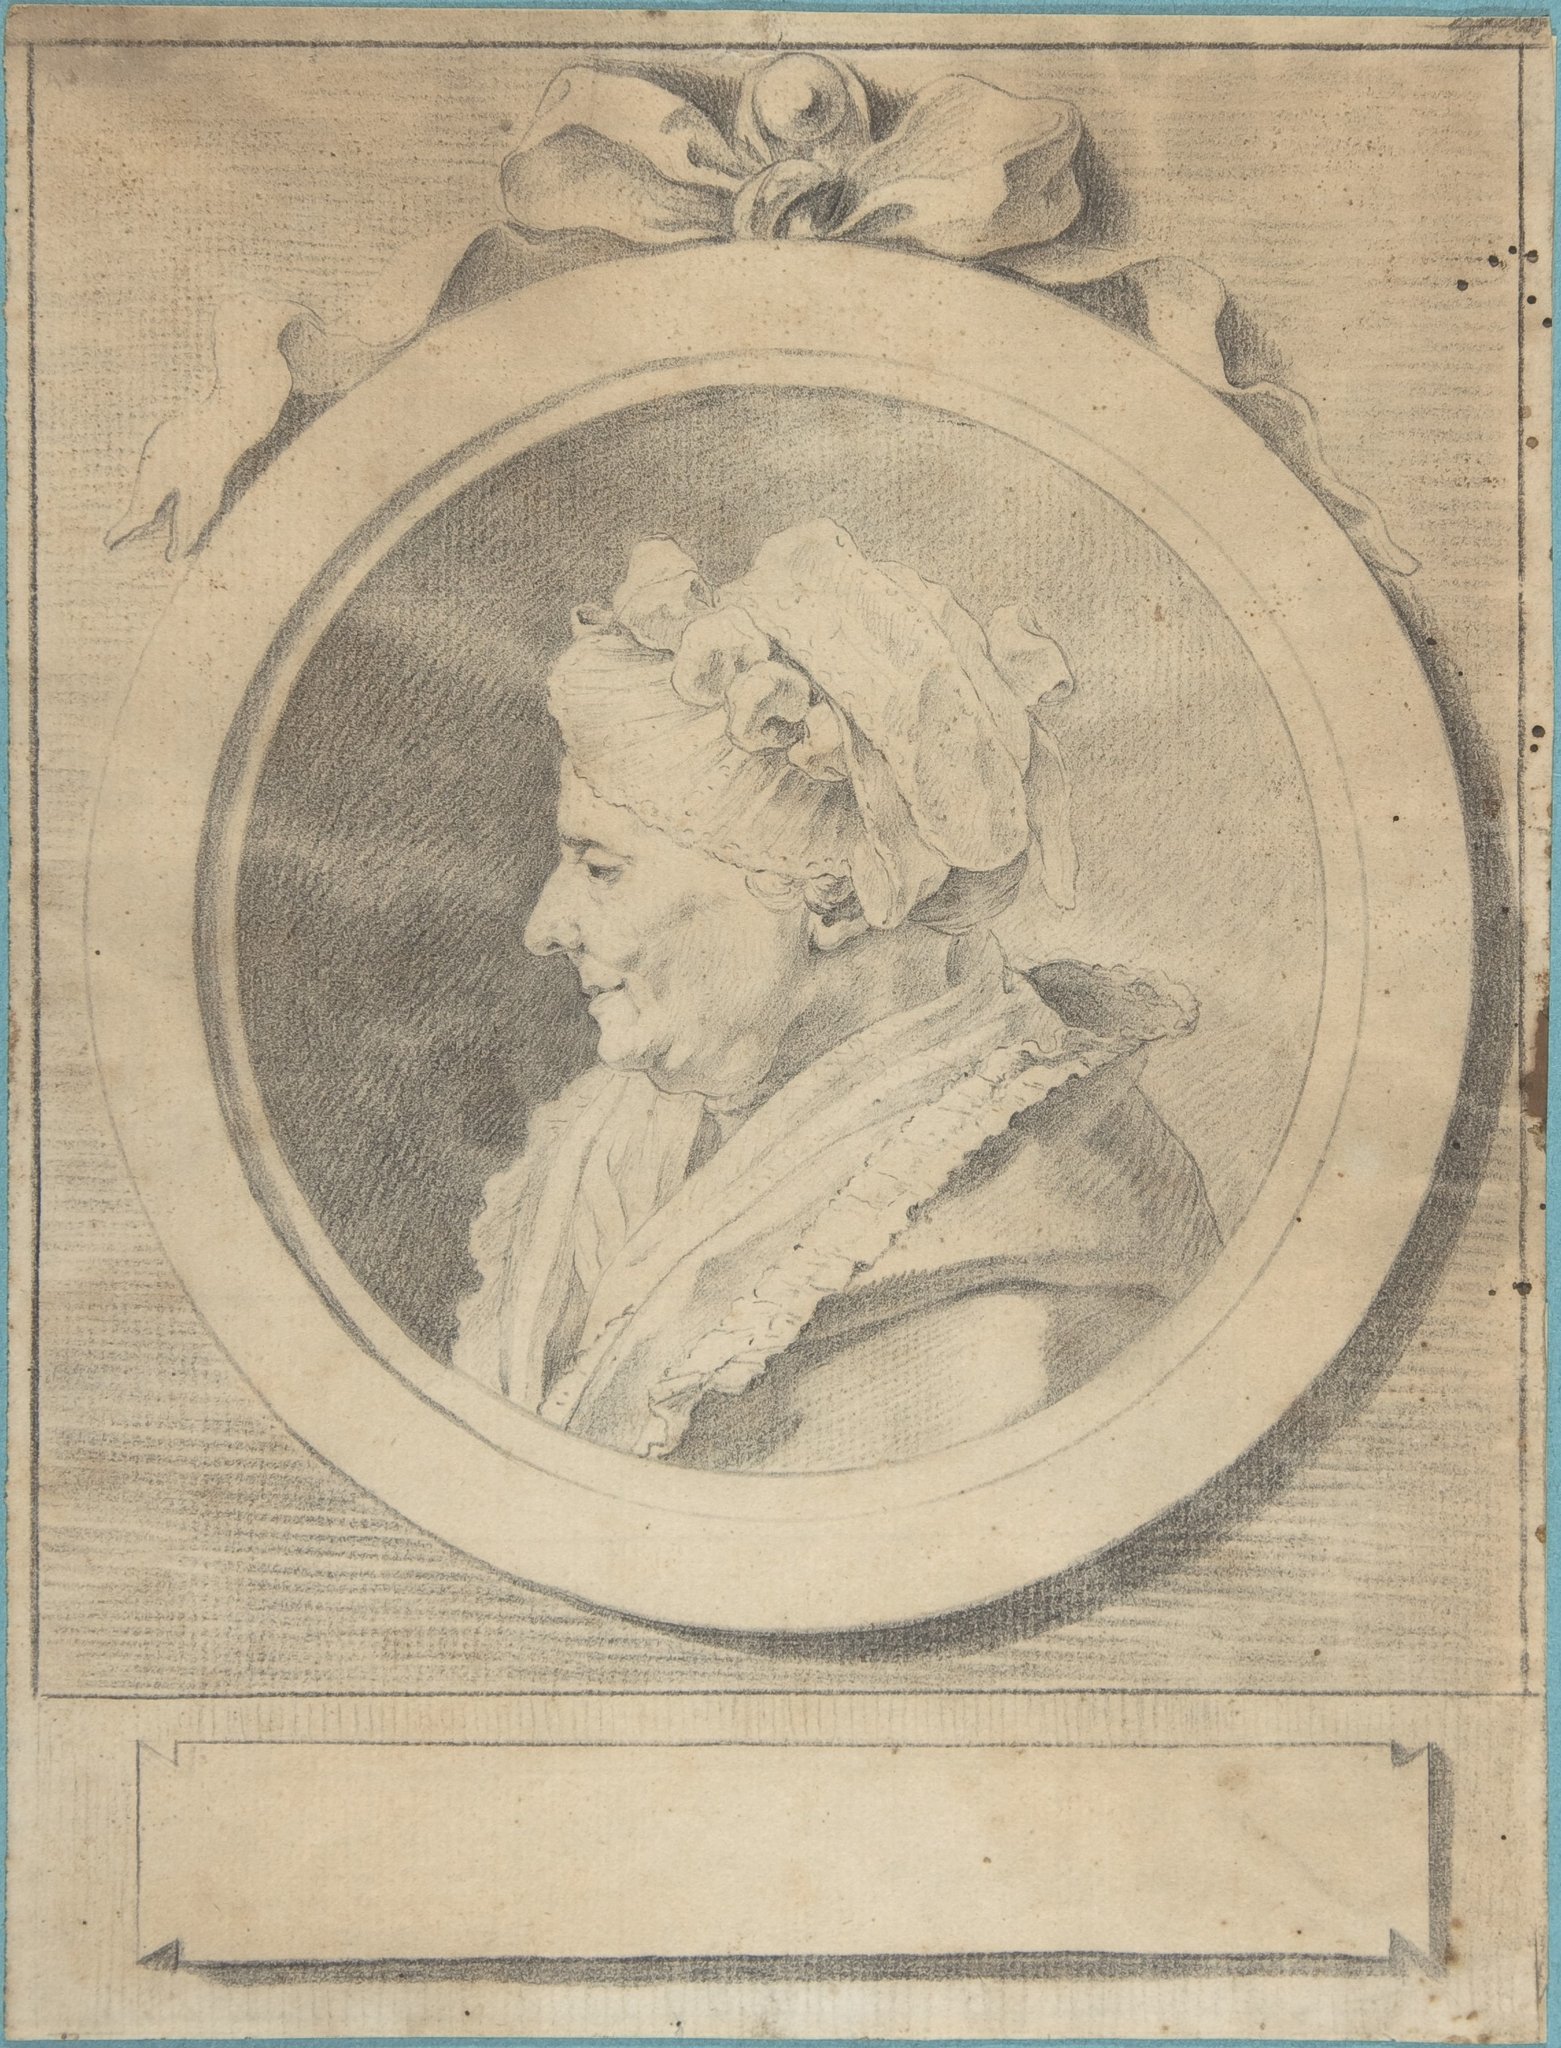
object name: drawing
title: Portrait of an Old Lady Wearing a Cap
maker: anonymous, french, 18th century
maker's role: artist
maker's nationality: french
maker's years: 1700-1800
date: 1701-1800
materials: graphite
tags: hats,profiles,women